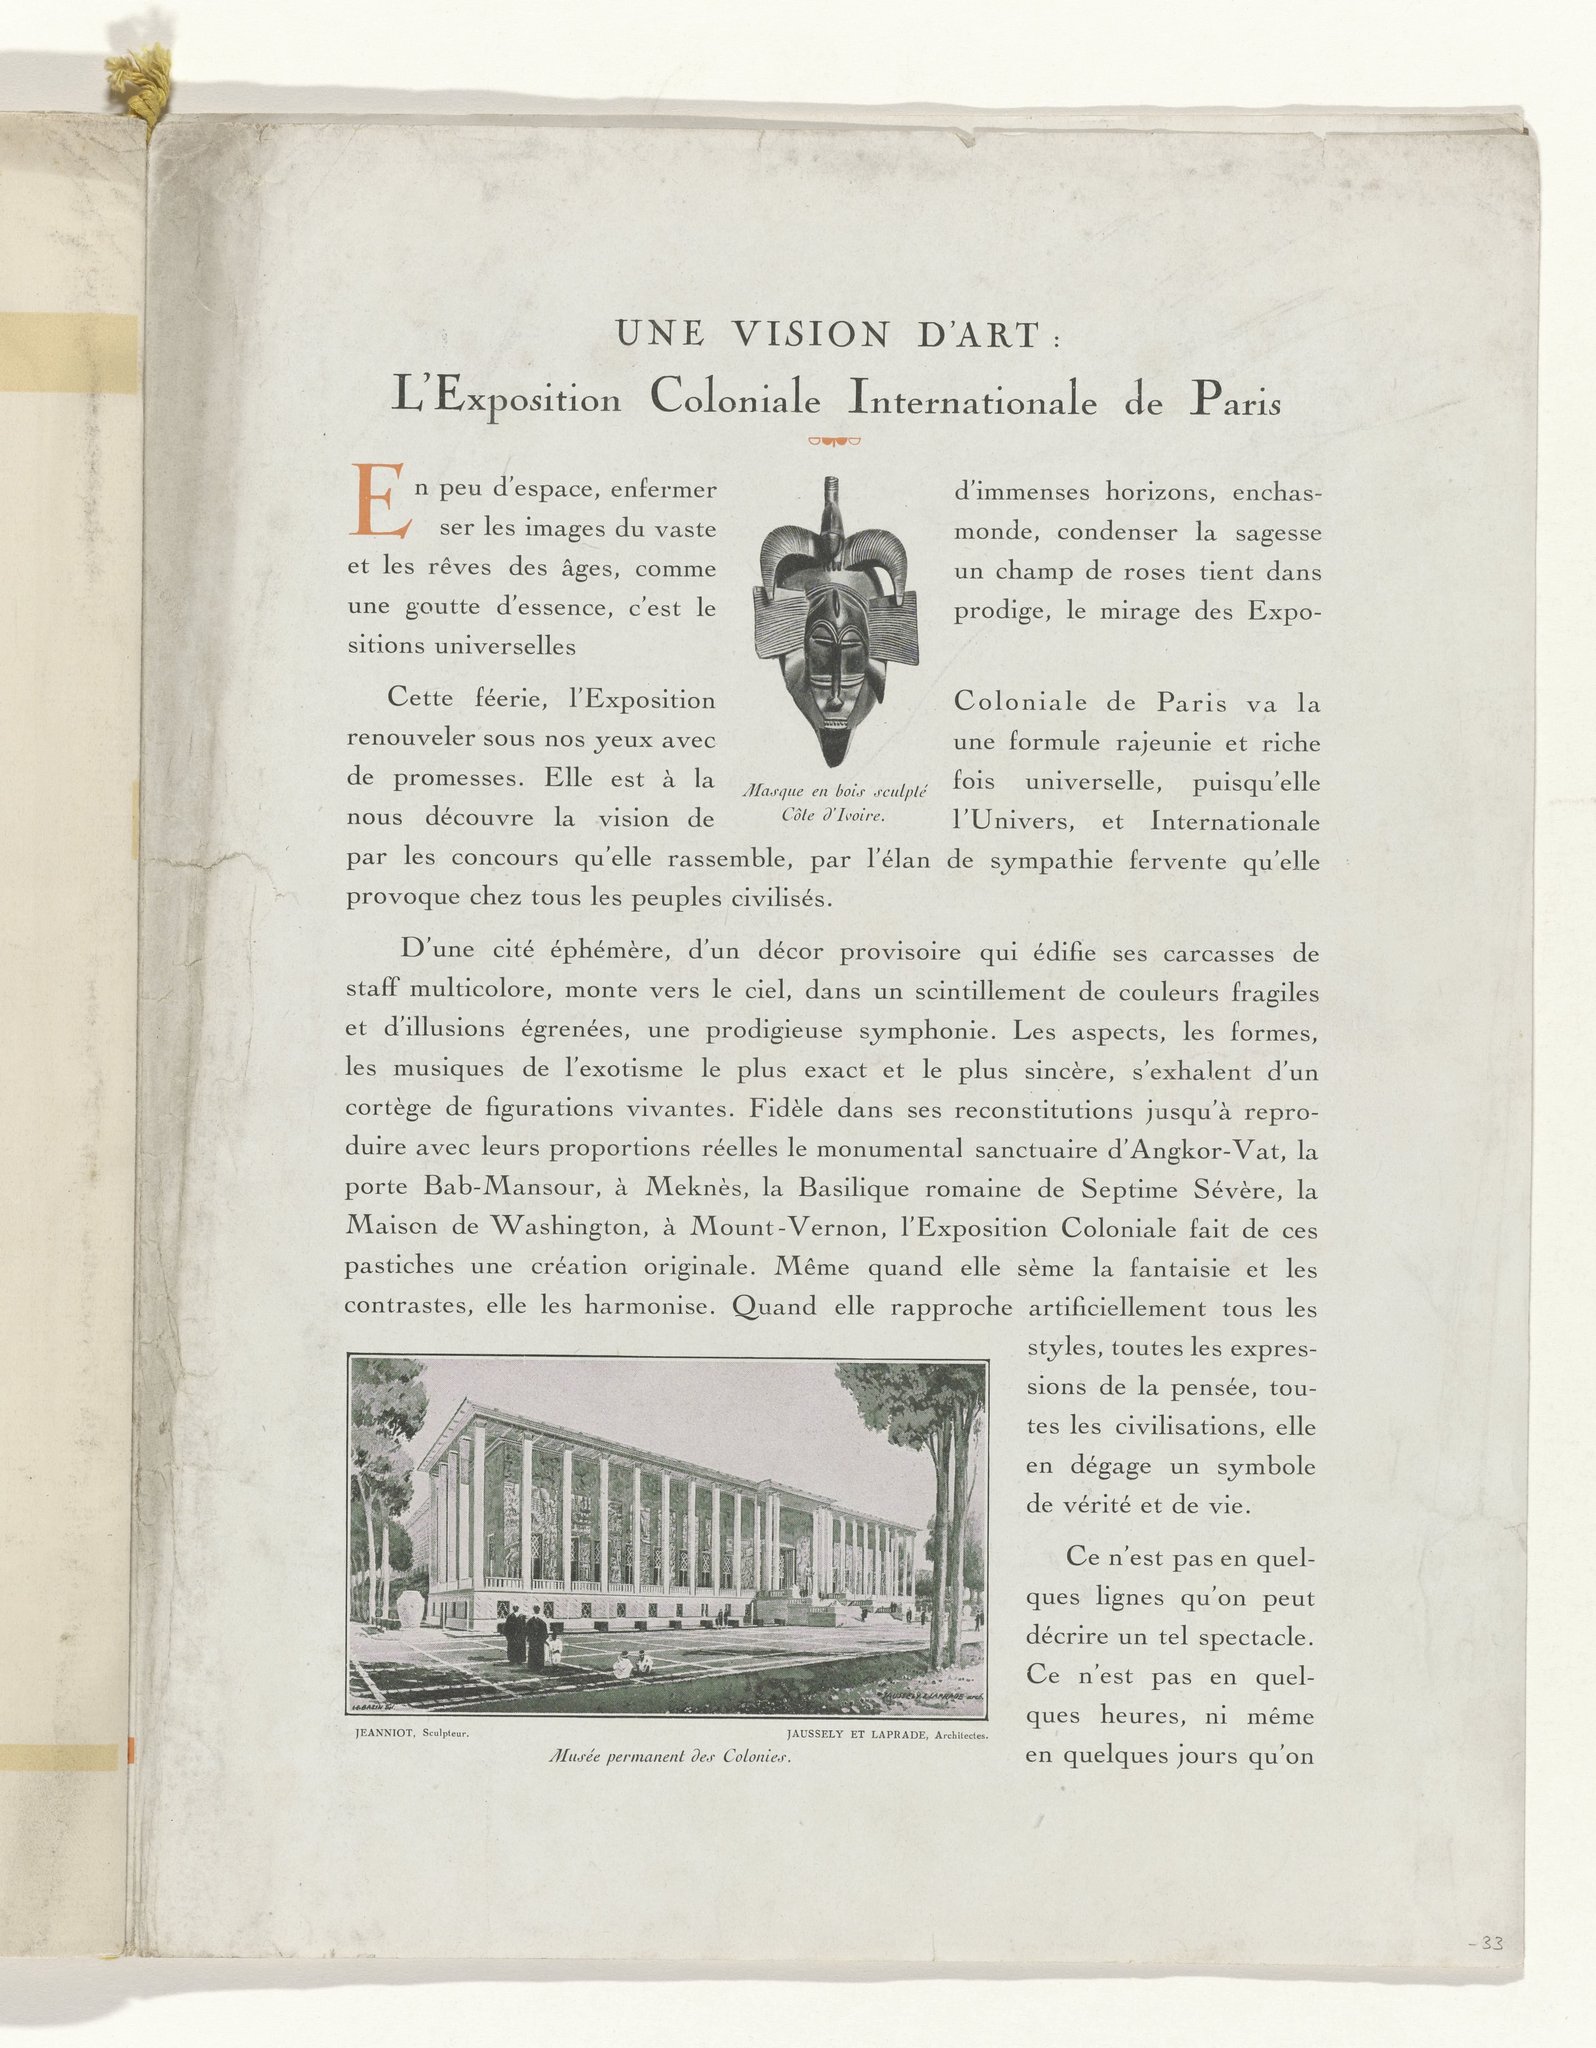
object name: magazine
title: Art - Goût - Beauté, Feuillets de l' élégance féminine, Mai 1931, No. 129, 11e Année, p. 33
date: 1931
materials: paper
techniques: printing, photography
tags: mask, fashion plates, permanent exhibition, museum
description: Tekst 'Une vision d'art: l'Exposition Coloniale Internationale de Paris' met twee afbeeldingen van een houten masker en het koloniaal museum ontworpen door Jaussely et Laprade (architecten) en Jeanniot (beeldhouwer). Pagina uit het modetijdschrift Art-Goût-Beauté (1920-1933).